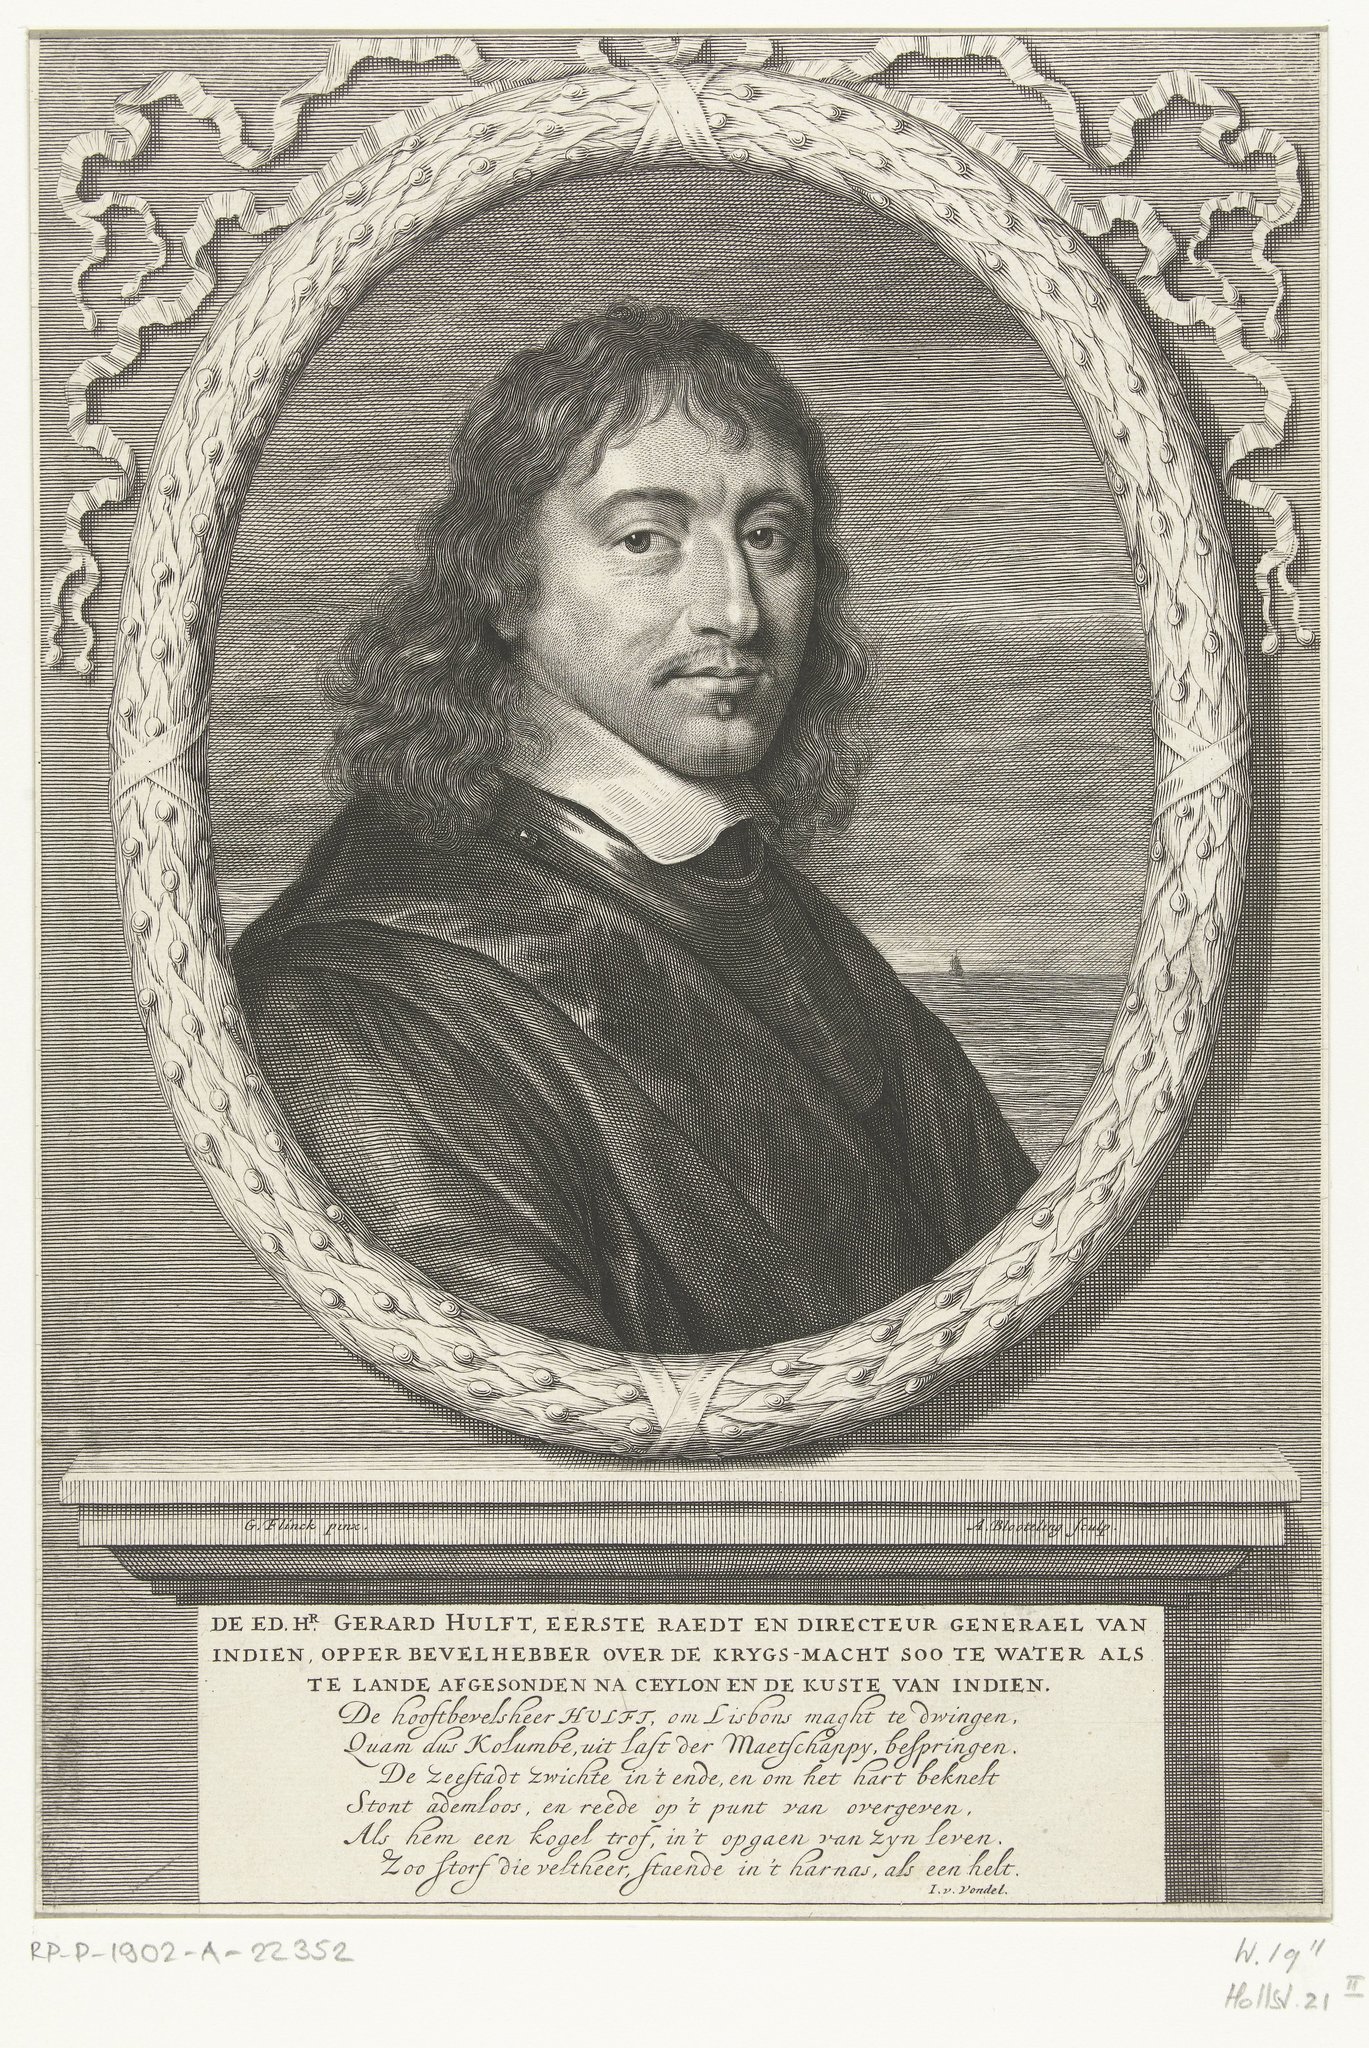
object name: print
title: Portret van Gerard Hulft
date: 1656-1690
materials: paper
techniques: engraving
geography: amsterdam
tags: amsterdam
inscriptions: collector's mark: Lugt 2228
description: Portret van Gerard Hulft, eerste directeur generaal van Nederlands-Indië. Borstbeeld met ovale omlijsting uit lauwerbladeren, op de achtergrond is een schip aan de horizon te zien. Onder het portret een Nederlands vers van Vondel over Hulsts leven en dood.